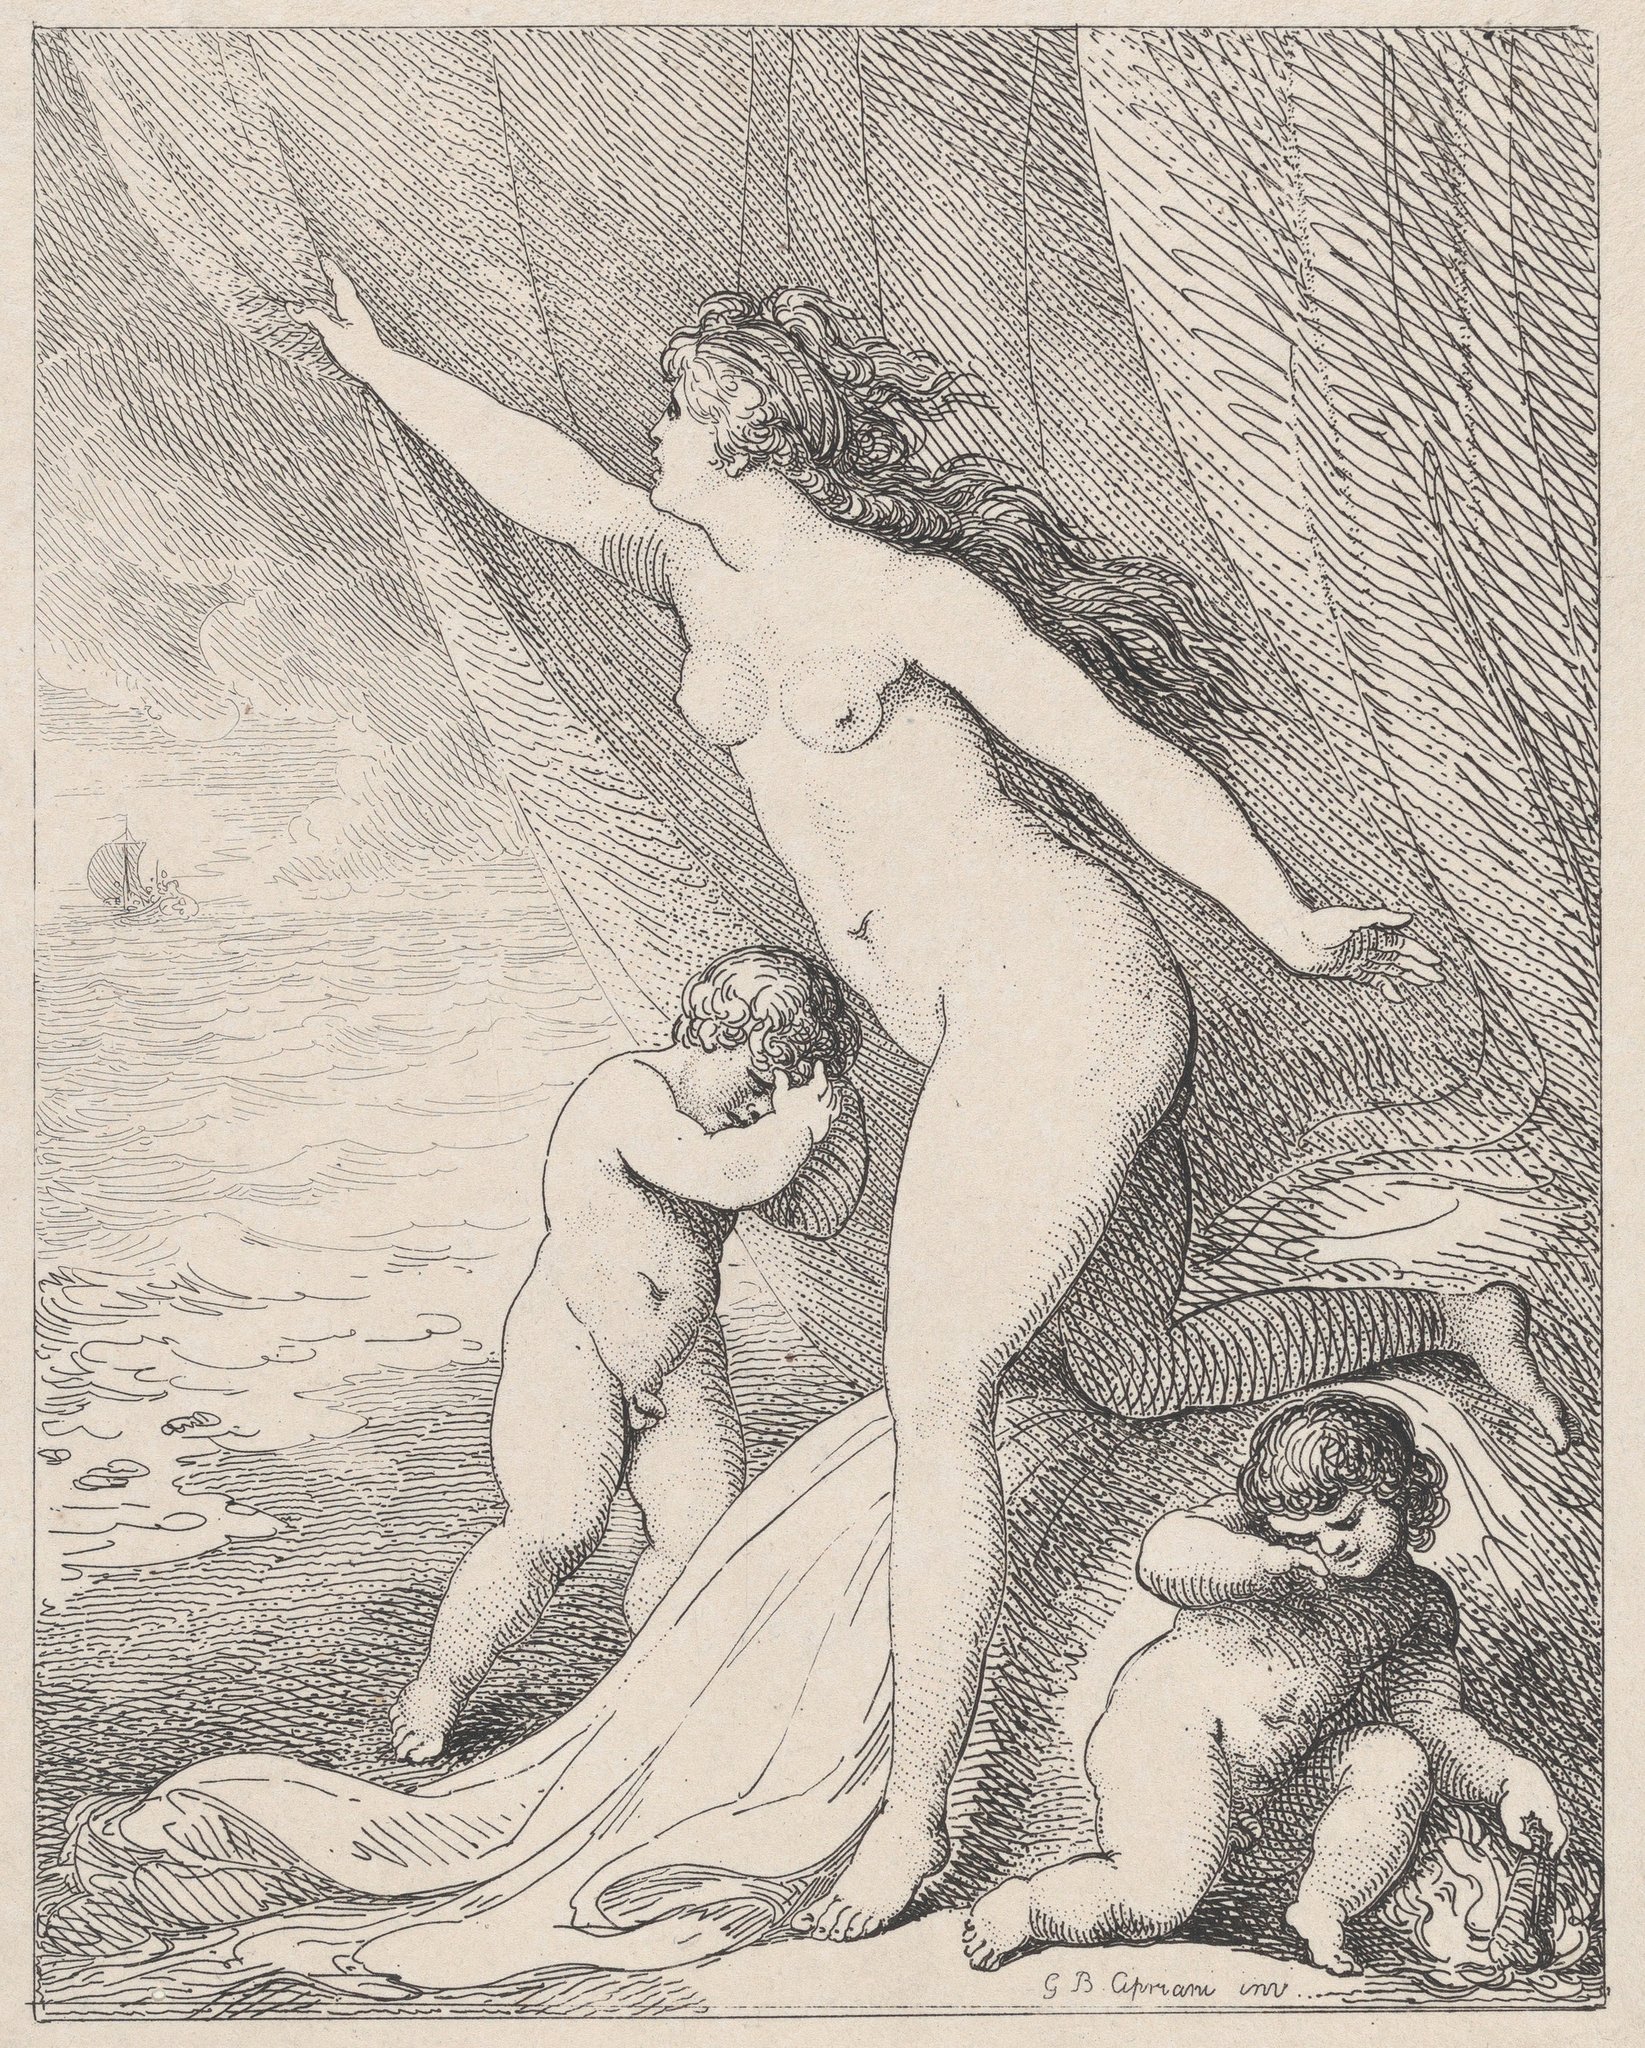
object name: print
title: Ariadne Abandoned by Theseus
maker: thomas rowlandson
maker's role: artist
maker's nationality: british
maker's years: 1757-1827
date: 1790-1799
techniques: etching, stippling